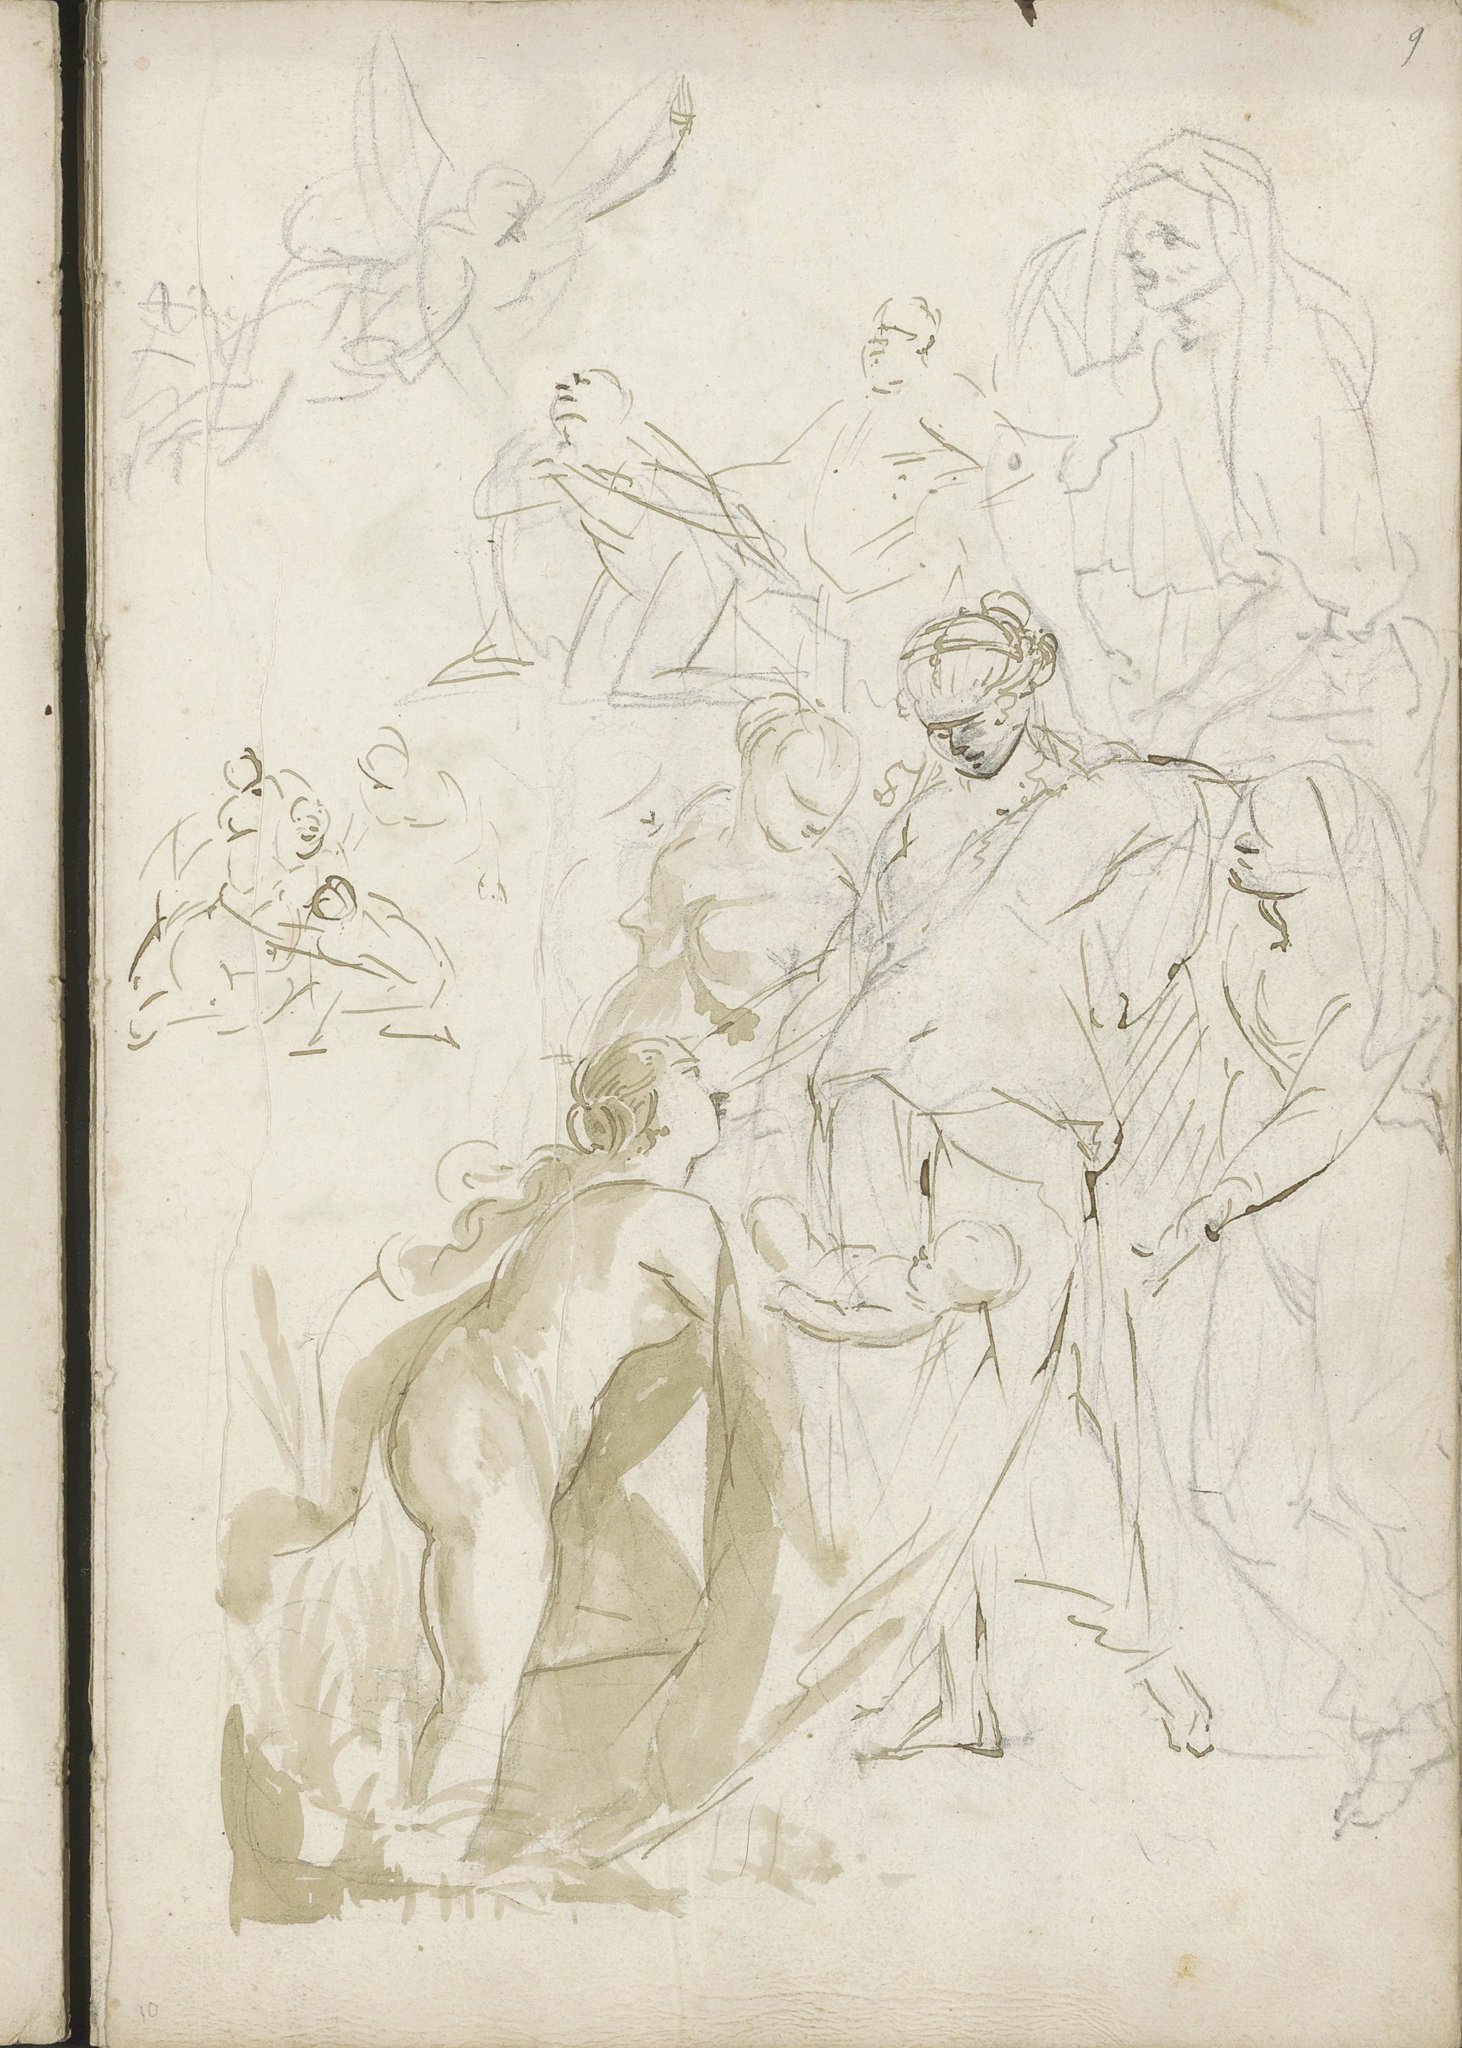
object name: sketchbook leaf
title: Vrouw die een kind omhoog houdt voor drie staande vrouwen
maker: Anonymous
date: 1650-1799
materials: ink, paper, pencil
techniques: brush, pen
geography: italy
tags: standing figure - aa - female human figure, other methods of carrying children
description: Tevens studies van een figuur in smekende houding en een gevleugelde figuur. Bladzijde 9 uit een schetsboek met 72 bladzijden.